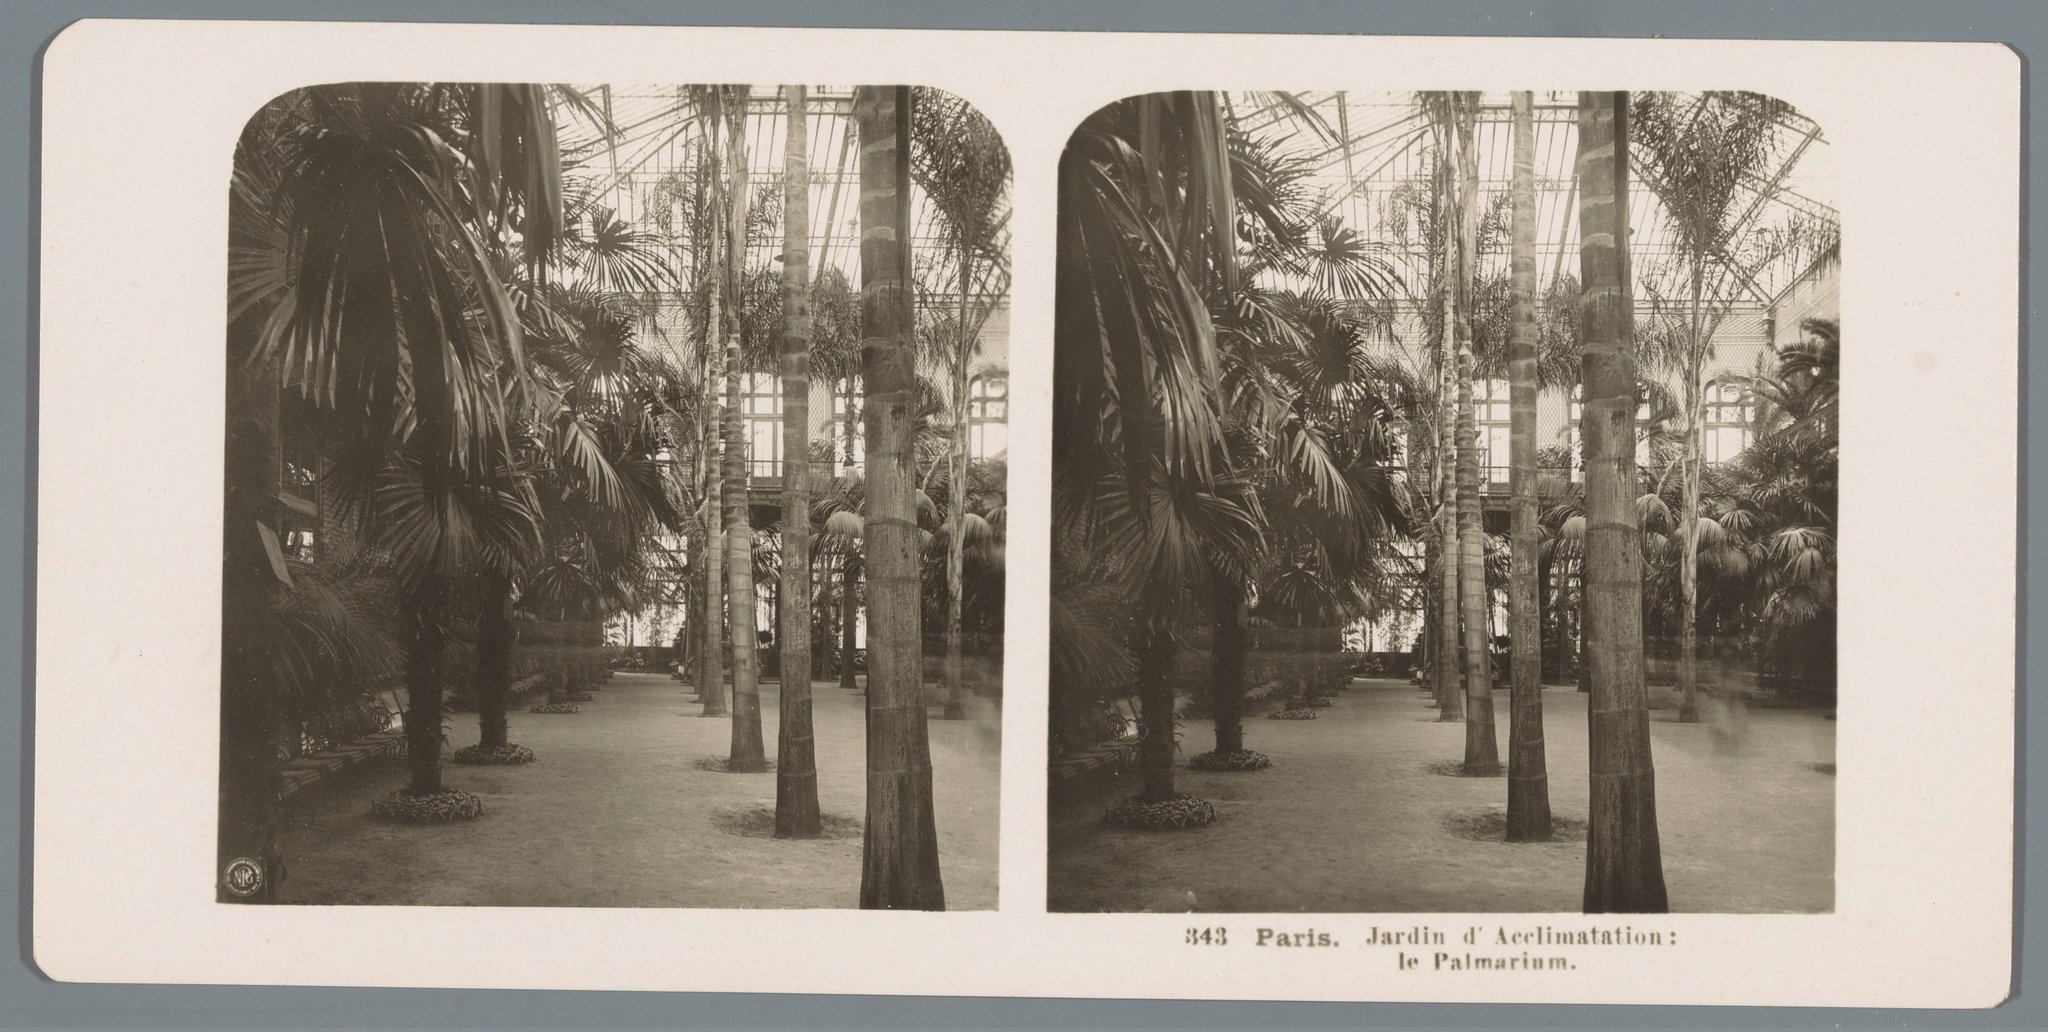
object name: stereograph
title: Palmentuin in de Jardin d'Acclimatation te Parijs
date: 1900-1910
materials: cardboard, photographic support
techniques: gelatin silver print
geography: jardin d'acclimatation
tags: trees: palm-tree, botanic garden, 'hortus botanicus', greenhouse, orangery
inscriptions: inscription: ‘NPG’, number: ‘343’